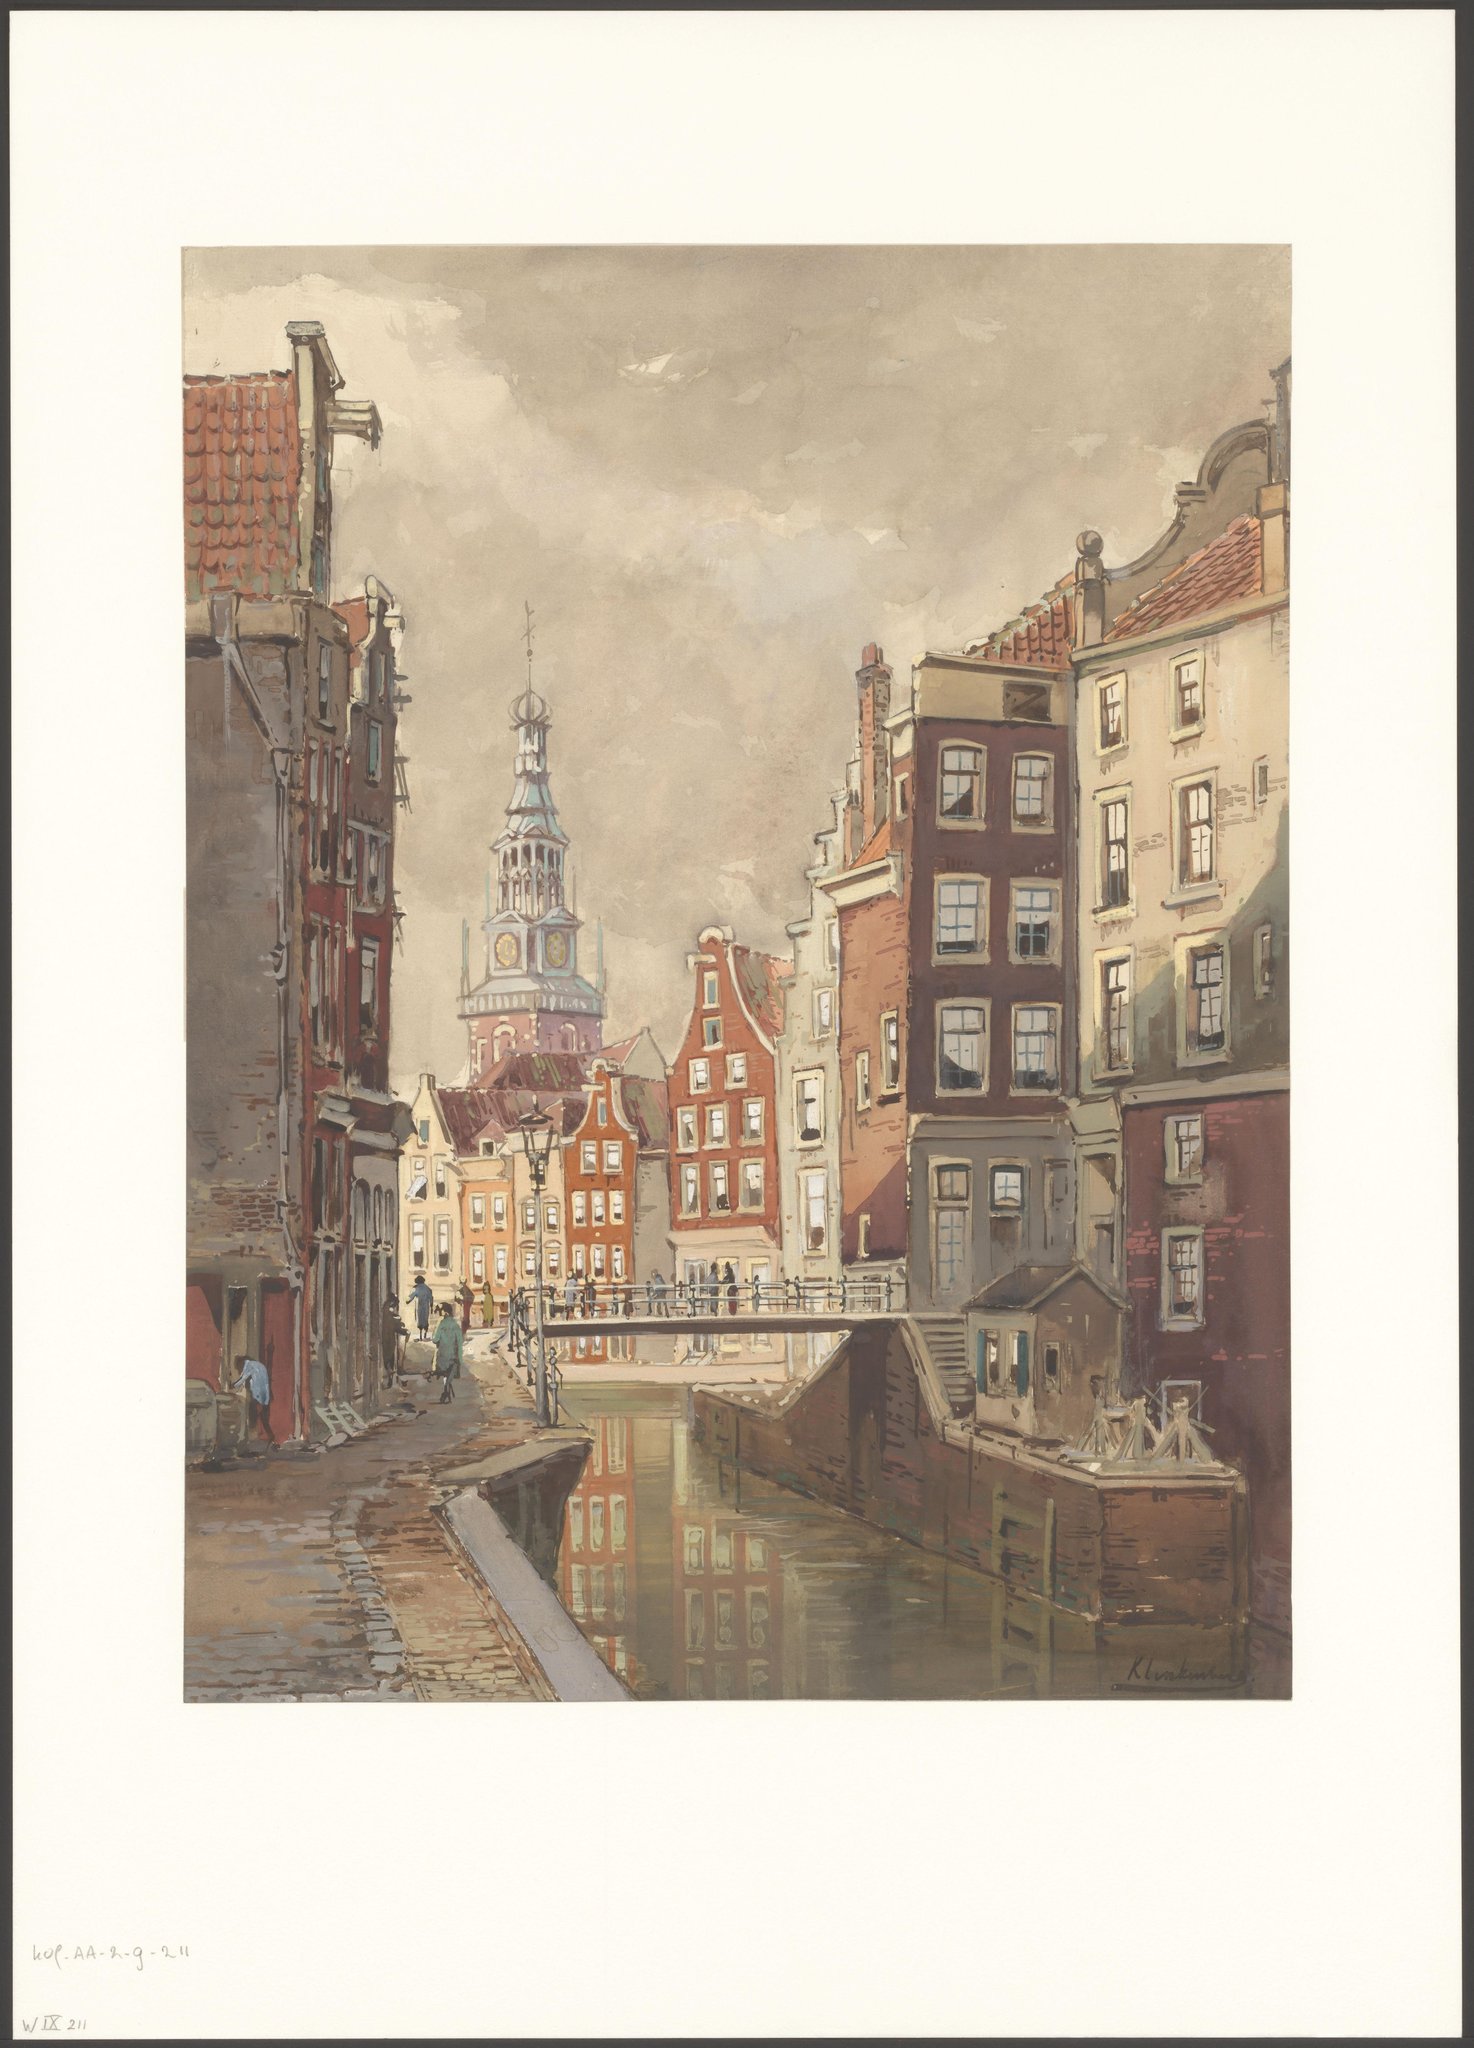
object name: drawing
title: Gezicht op de Oudezijds Kolk en de Kolksluis gezien naar de Oudekerkstoren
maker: johannes christiaan karel klinkenberg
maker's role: draughtsman, painter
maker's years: 1852-1924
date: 1862-1924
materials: gouache, paper, pencil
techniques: brush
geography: amsterdam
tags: city-view in general; 'veduta', canal, parts of church exterior and annexes: spire, bridge in city across river, canal, etc.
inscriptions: collector's mark: Lugt 800a, signature: ‘Klinkenberg’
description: Tekening binnen de Atlas Van Eck ingedeeld op wijknummer 9.